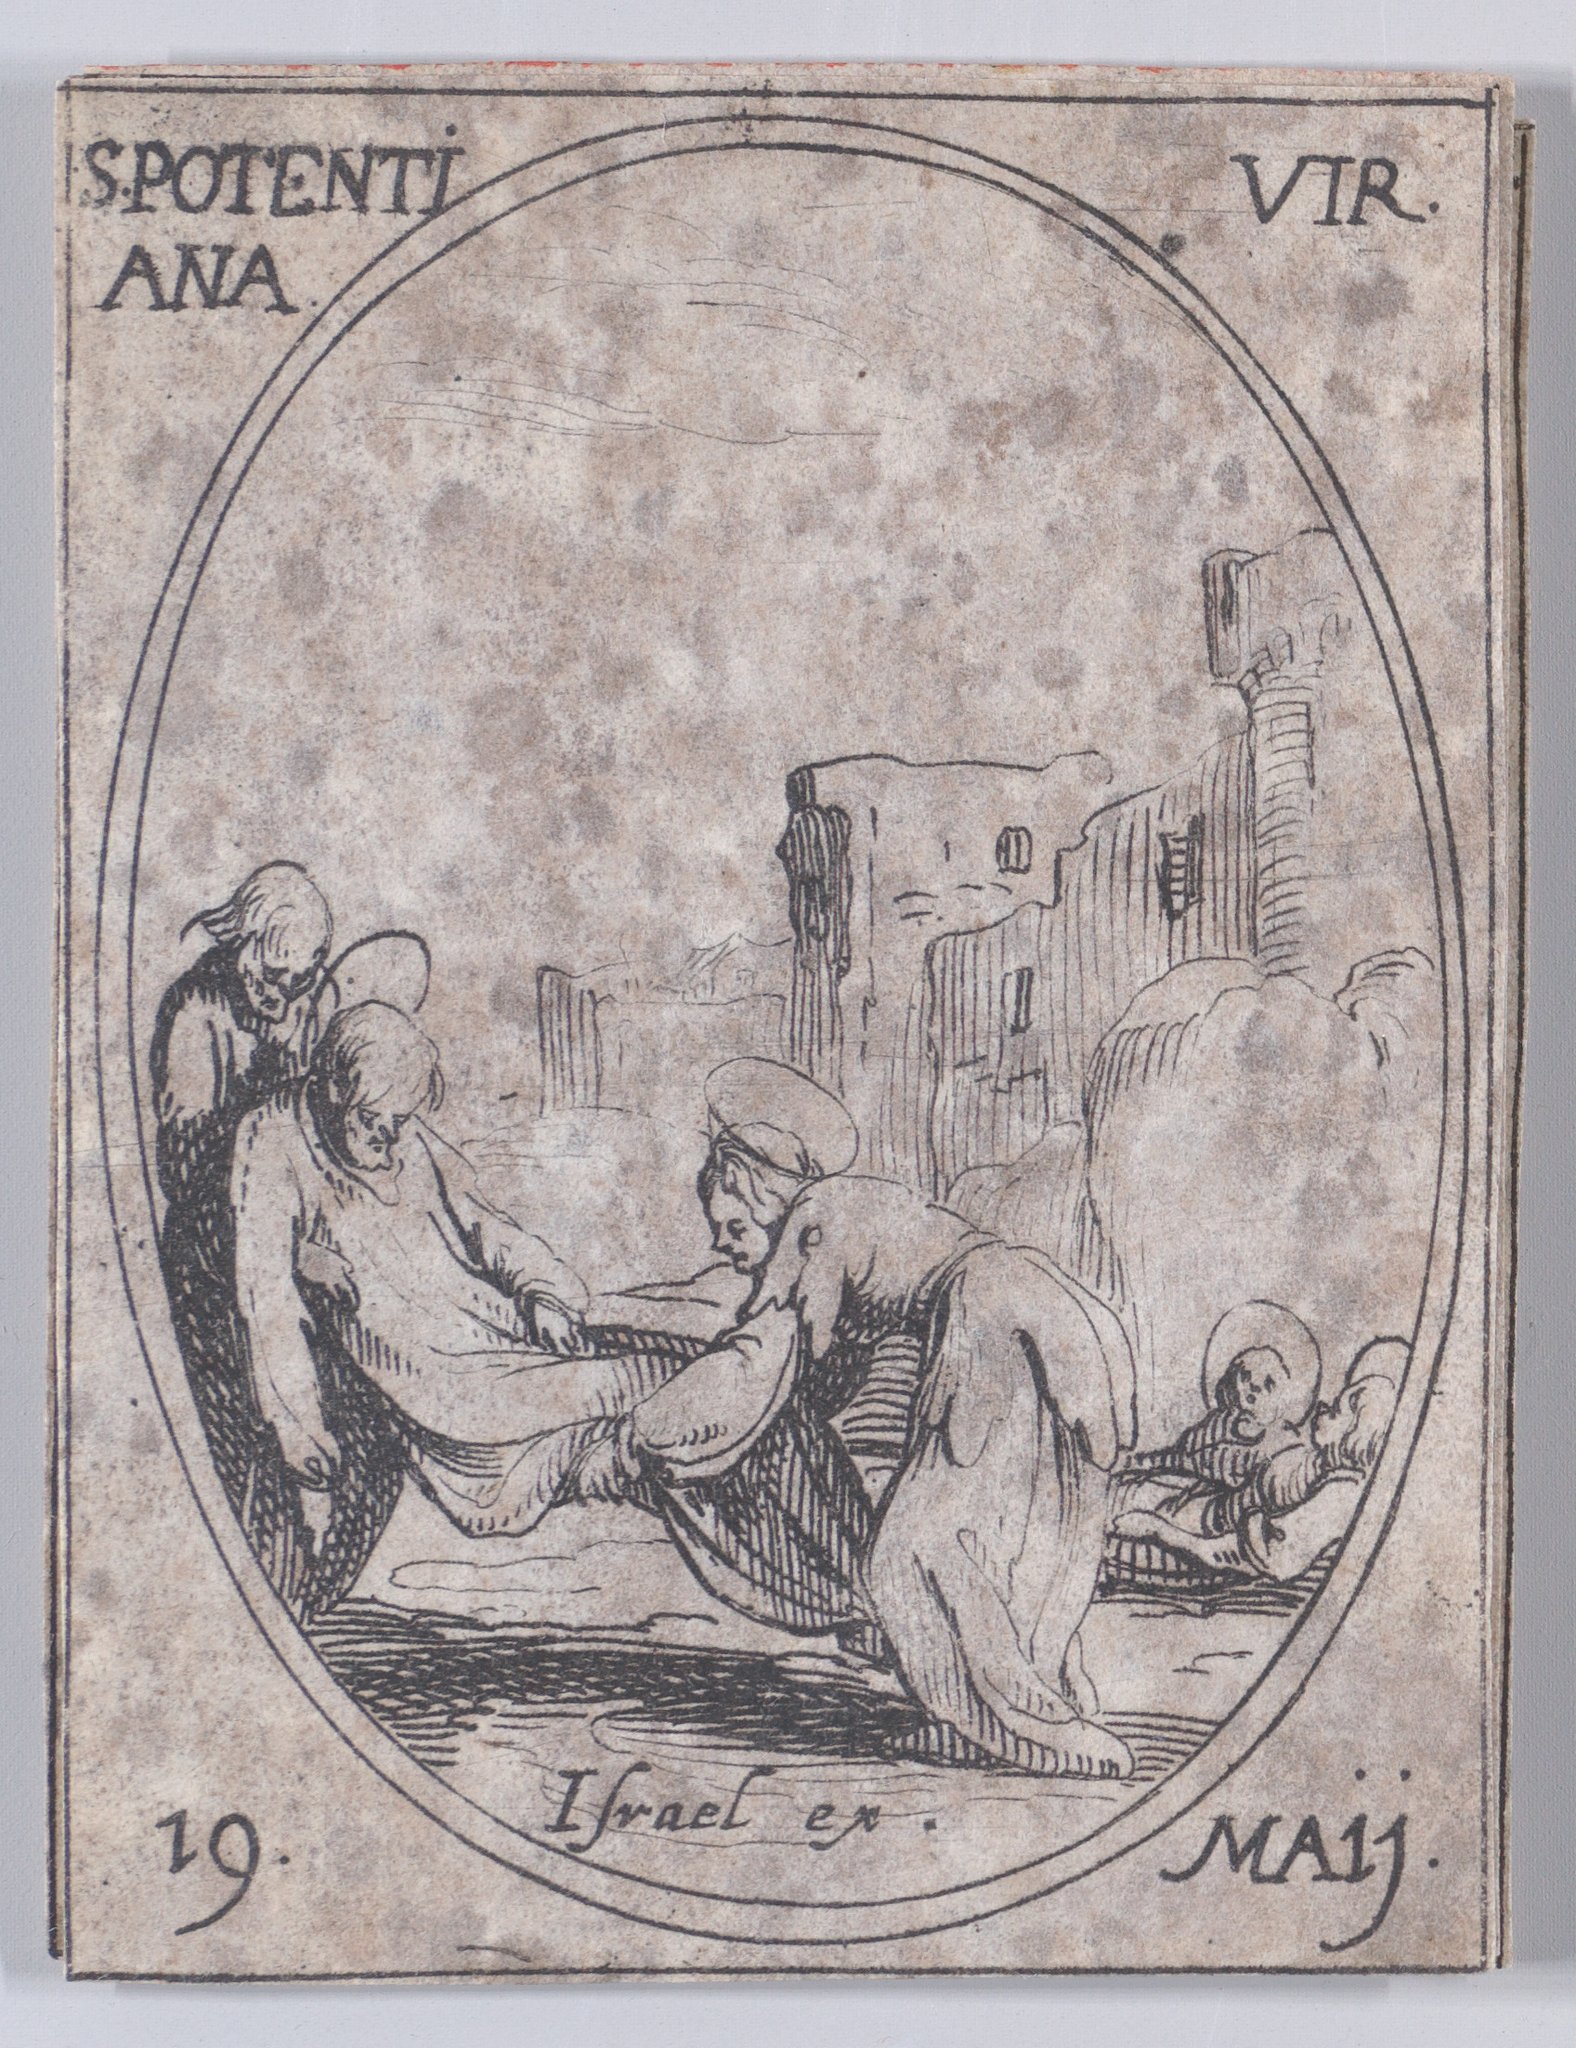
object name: print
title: Ste. Potentienne, vierge (St. Pudentiana, Virgin), May 19th, from "Les Images De Tous Les Saincts et Saintes de L'Année" (Images of All of the Saints and Religious Events of the Year)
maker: jacques callot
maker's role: artist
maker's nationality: french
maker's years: 1592-1635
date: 1636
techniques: etching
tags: men,women,saints